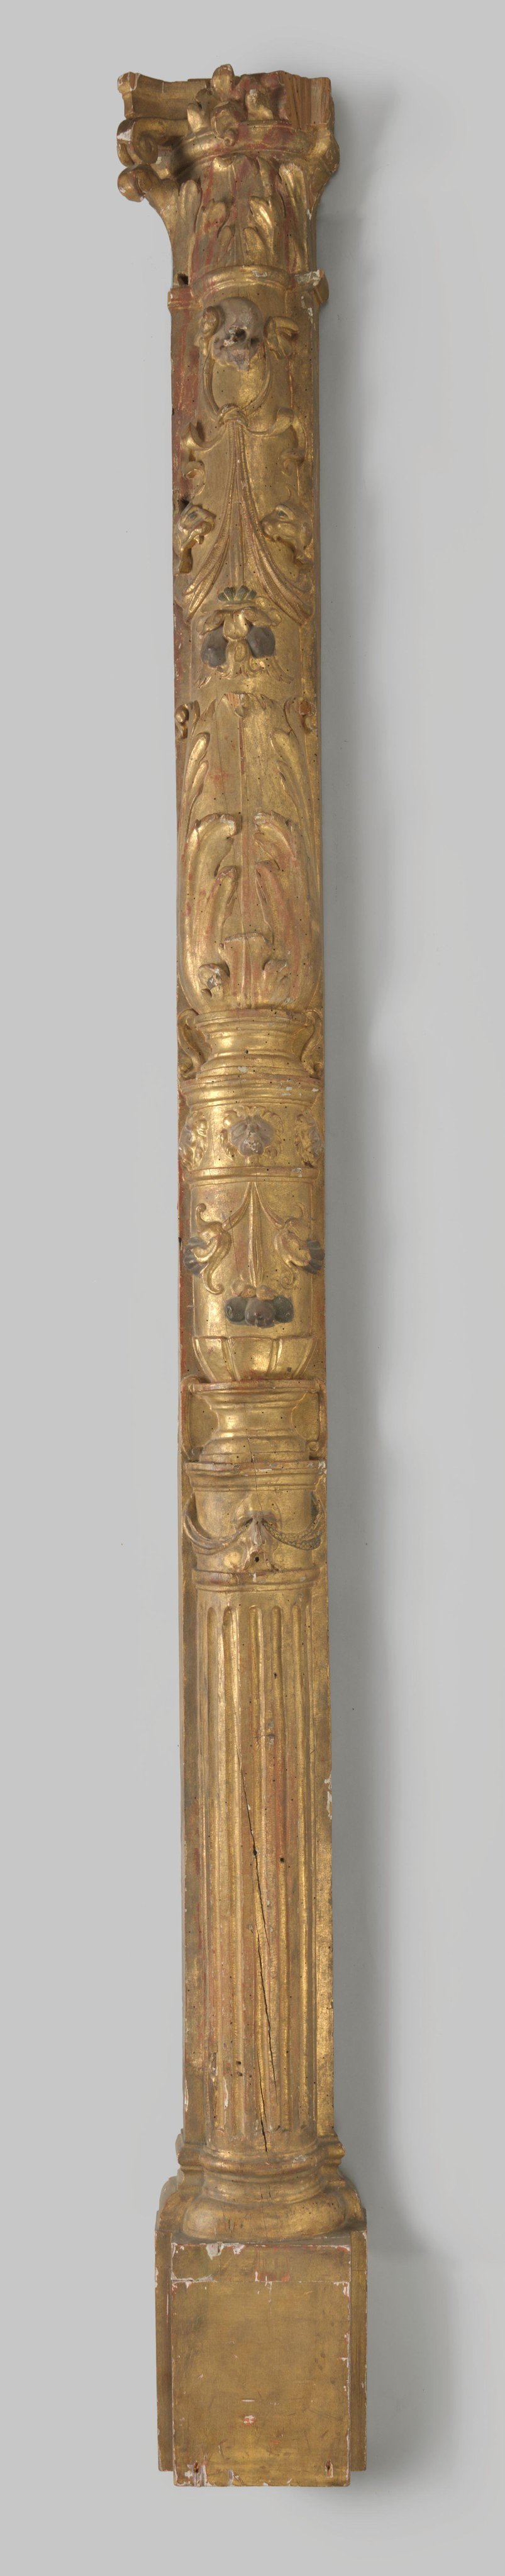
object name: surround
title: Onderdeel van een raamomlijsting. Gestoken pilaster van verguld hout in de vorm van een halfzuil met composietkapiteel.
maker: Anonymous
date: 1500-1550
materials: wood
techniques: gilding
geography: spain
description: Gestoken pilaster van verguld hout in de vorm van een halfzuil met composietkapiteel. Het bovendeel van de schacht is vaasvormig geleed en vertoont mascarons met afhangende guirlandes. Vormt samen met een tweede pilaster en een geprofileerde kroonlijst een raamomlijsting. Zie tevens: BK-16892-B & -C. Afkomstig uit de tuinkamer van de villa van Mannheimer (huidige Bureau).